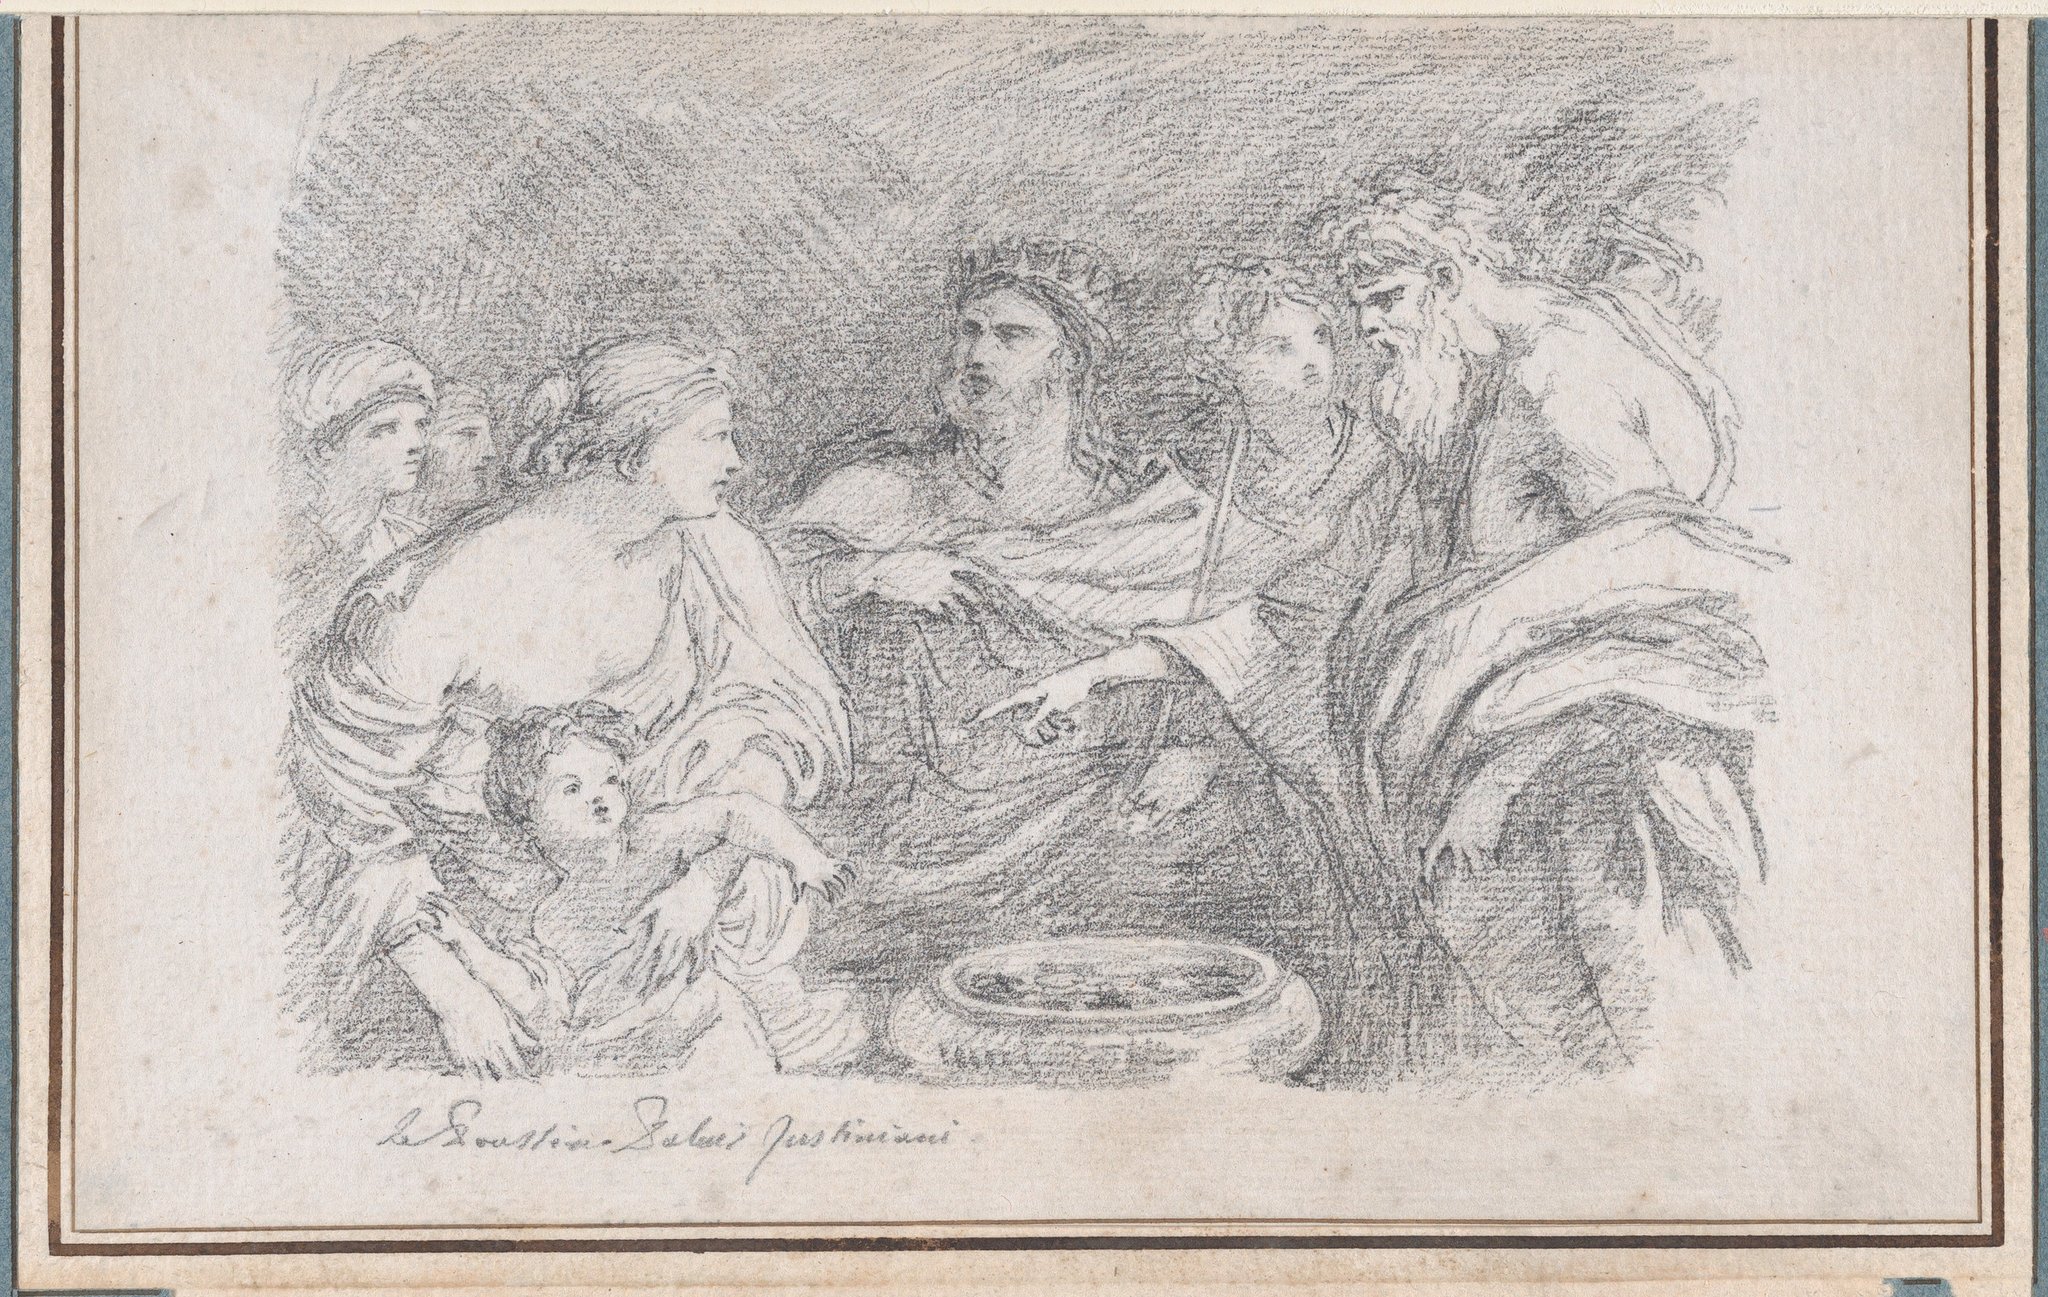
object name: drawing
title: The Infant Moses before Pharaoh, after Giovanni Battista Ruggieri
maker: jean robert ango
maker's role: artist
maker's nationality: french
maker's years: 1759-1773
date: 1759-1770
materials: chalk, ink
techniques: pen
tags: infants,men,women,moses